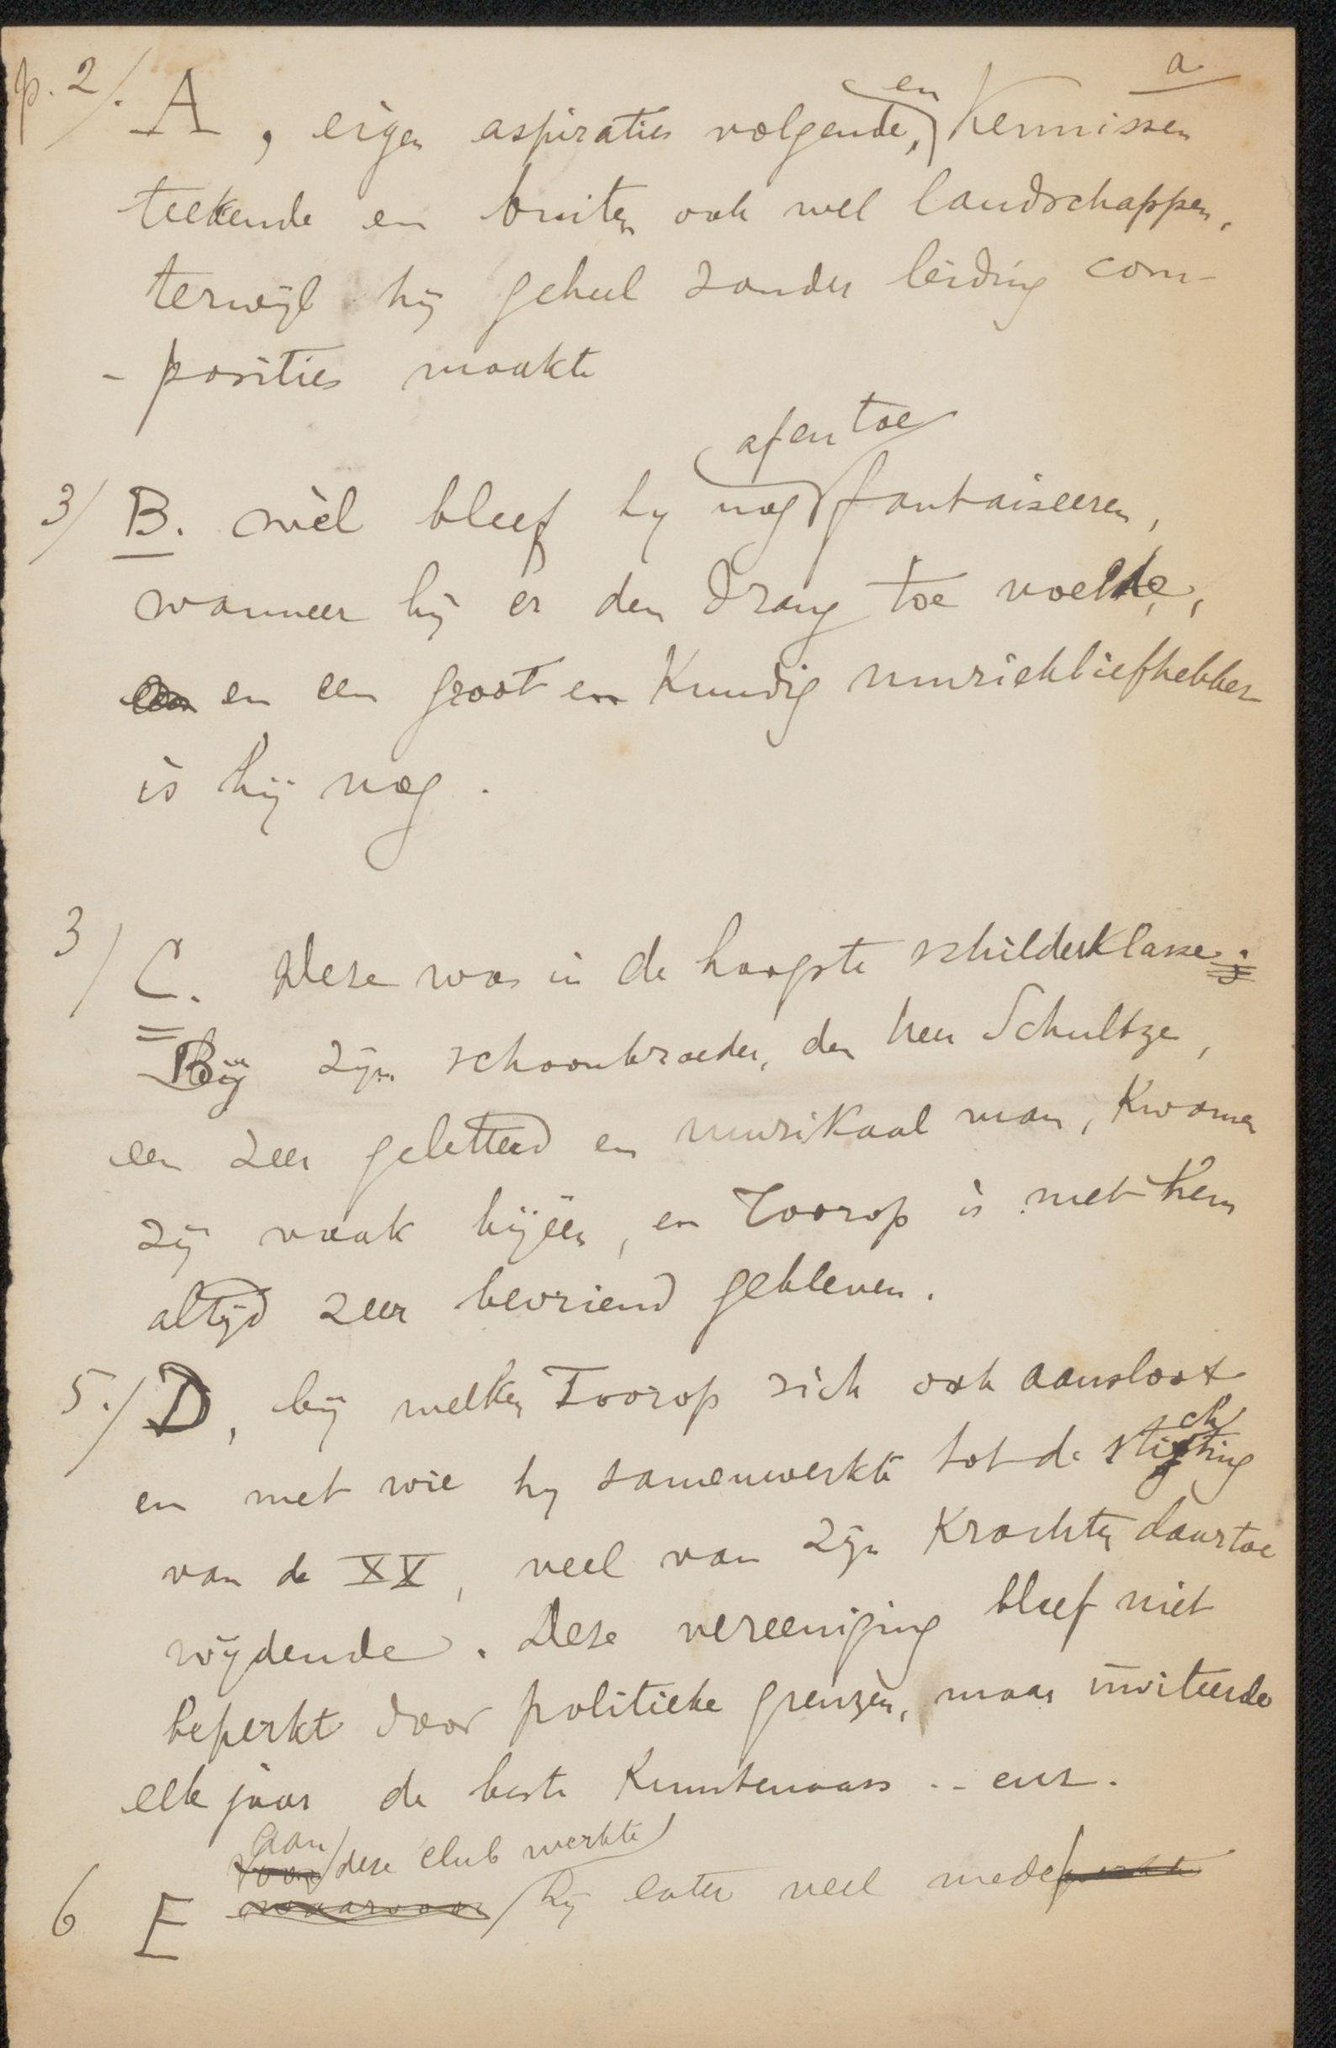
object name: aantekening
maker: philip zilcken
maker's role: draughtsman, painter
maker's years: 1857-1930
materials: ink, paper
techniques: pen, writing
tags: print maker, jan toorop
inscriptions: watermark, collector's mark: ‘RPK’